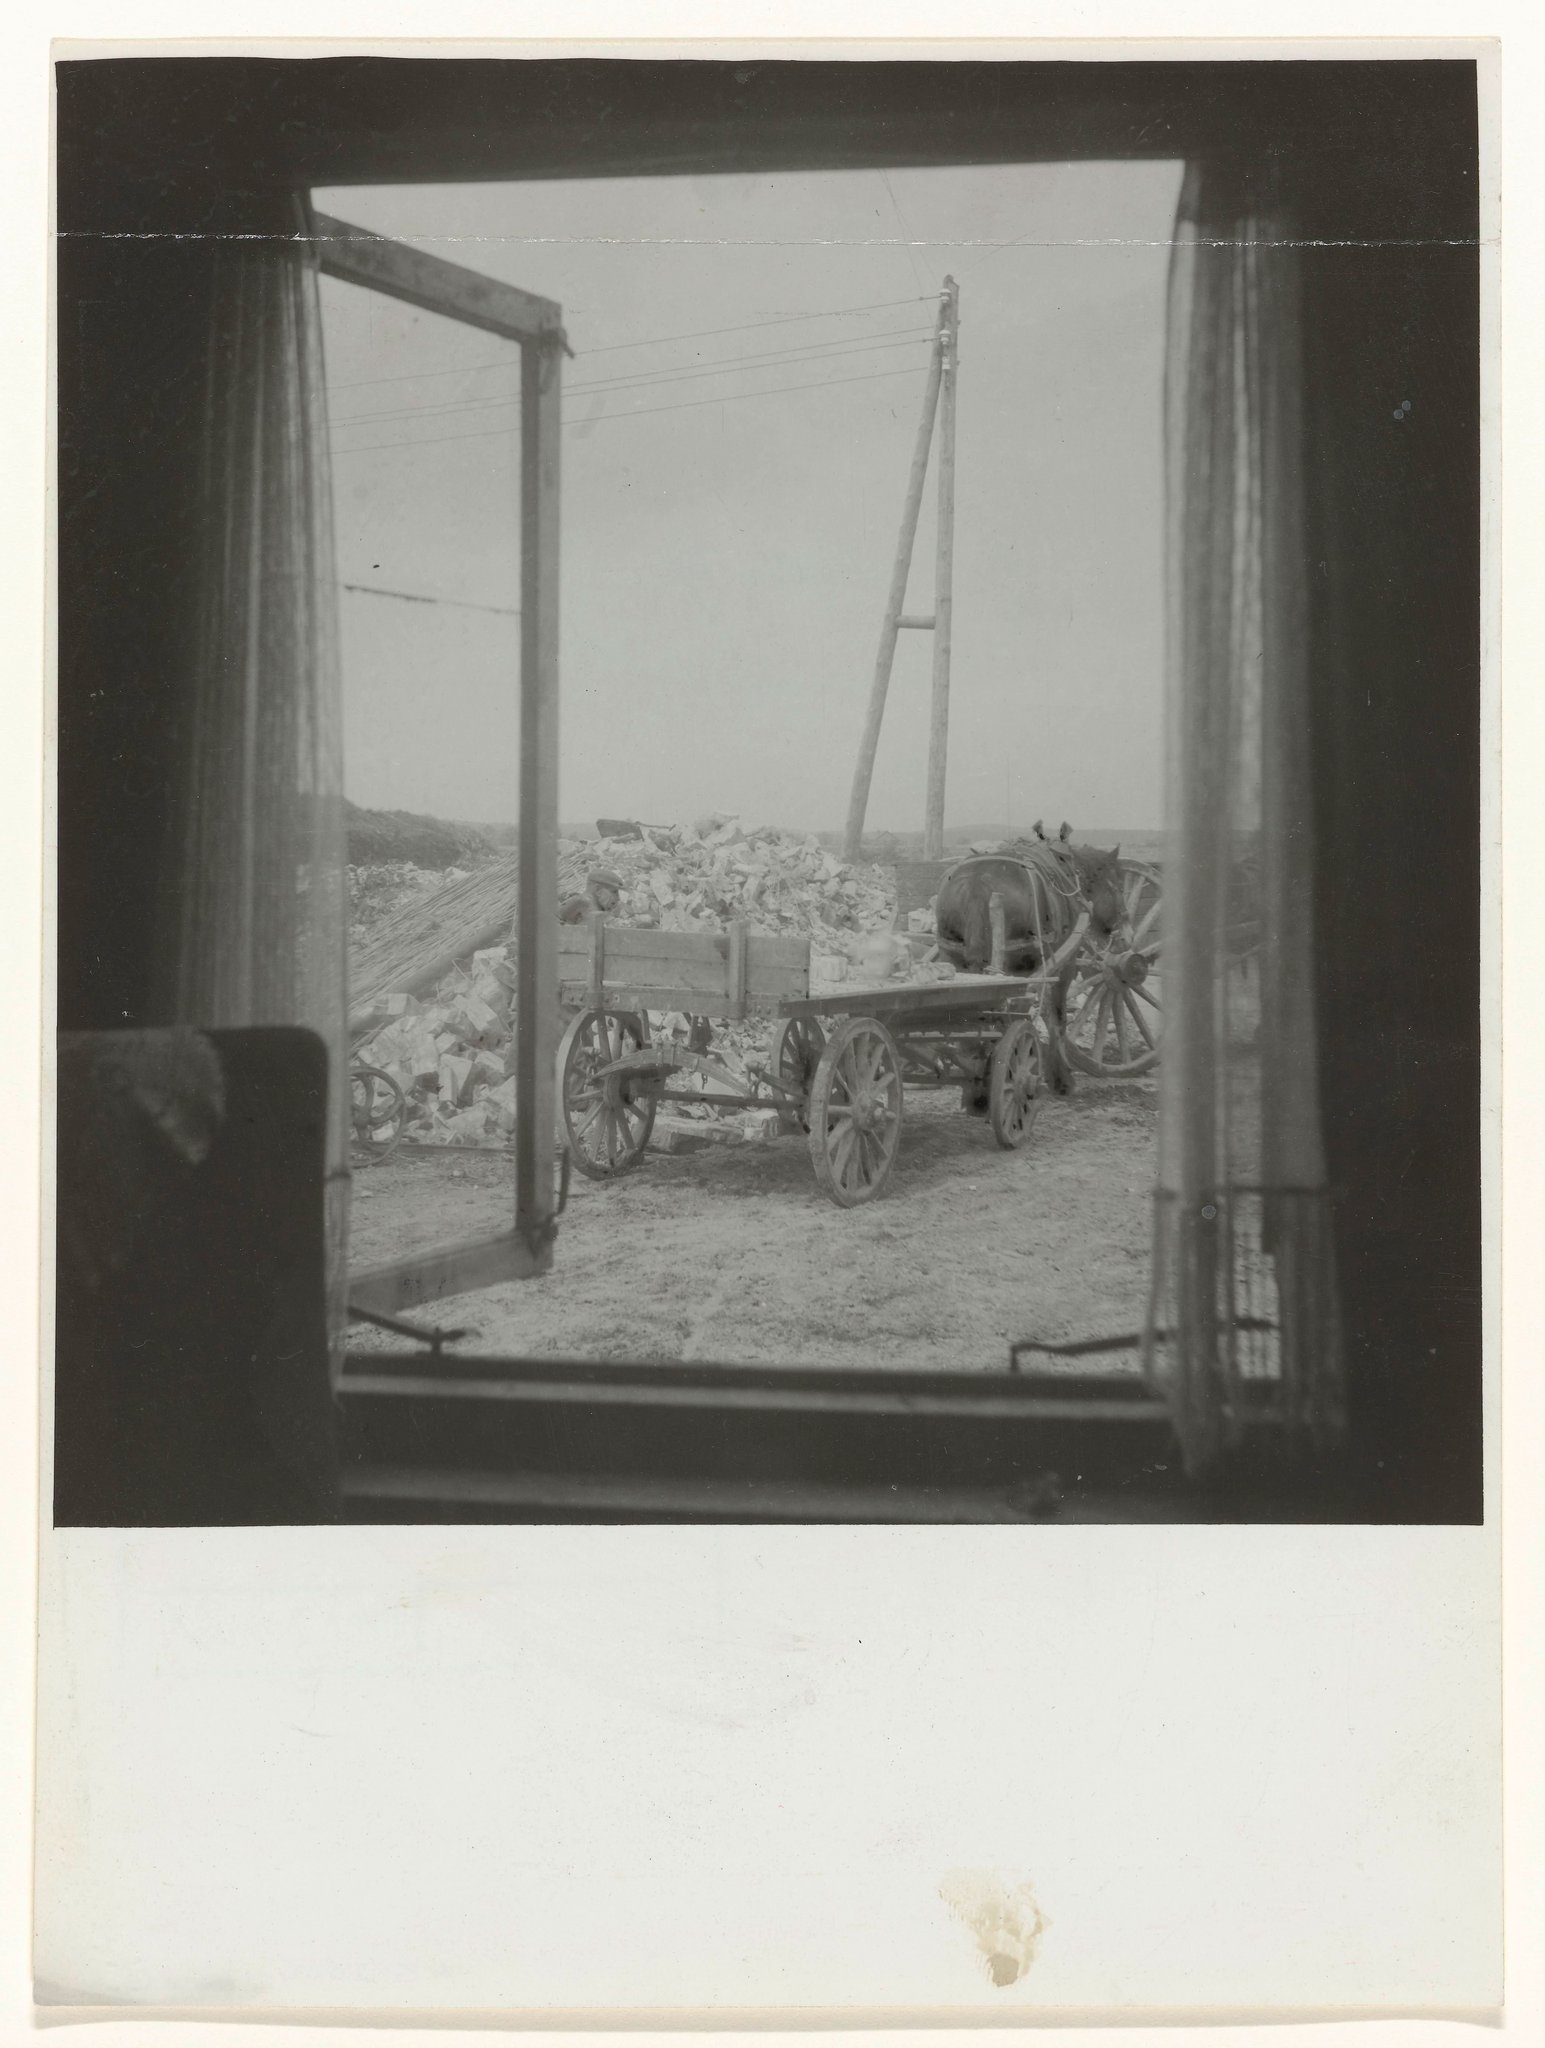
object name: documentary photograph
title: Paard en wagen bij een berg puin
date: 1945-1947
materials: photographic support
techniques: photography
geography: netherlands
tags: netherlands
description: Door een geopend raam is zicht op paard en wagen. Een man is bezig puin op de wagen te gooien.